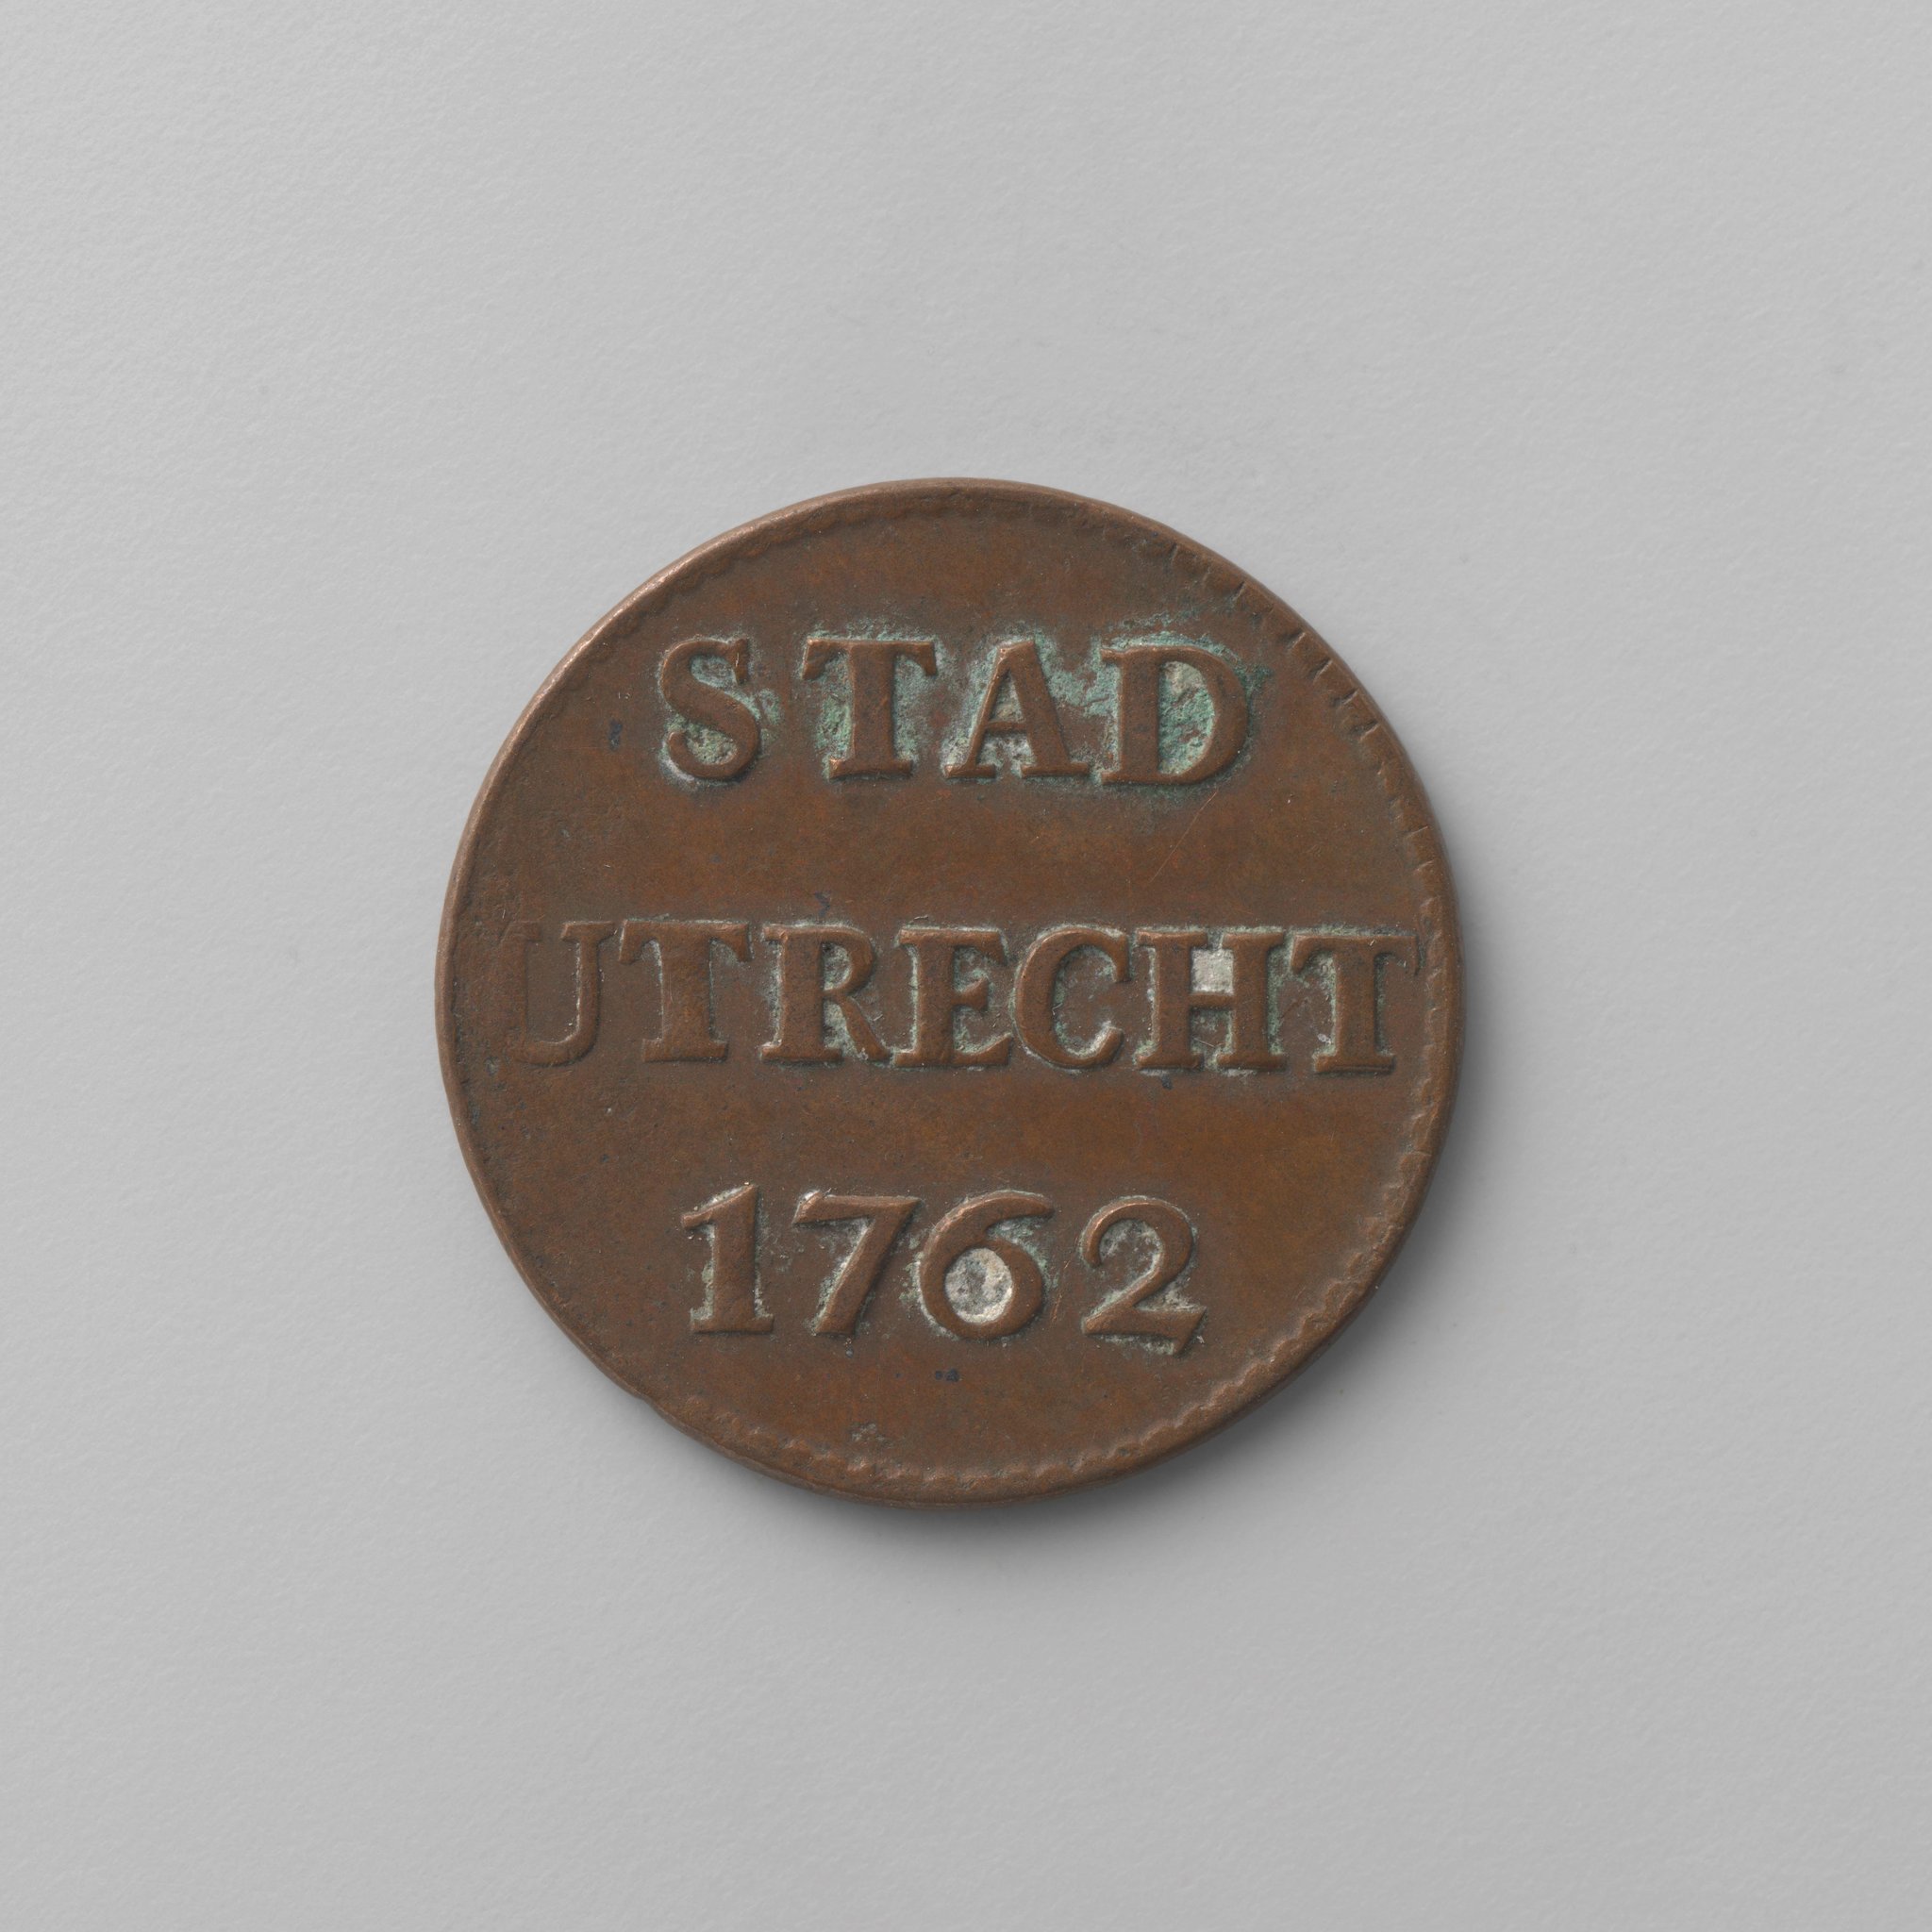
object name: coin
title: Duit van de stad Utrecht, 1762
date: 1762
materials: copper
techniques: striking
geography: utrecht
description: Koperen munt. Voorzijde: gekroond stedelijk wapenschild, gehouden door twee leeuwen met in afsnede dikke lijn, waaronder een versierde accolade met een grote schelp. Keerzijde: opschrift in twee regels, waaronder jaartal. Jaartal met Arabische 1.